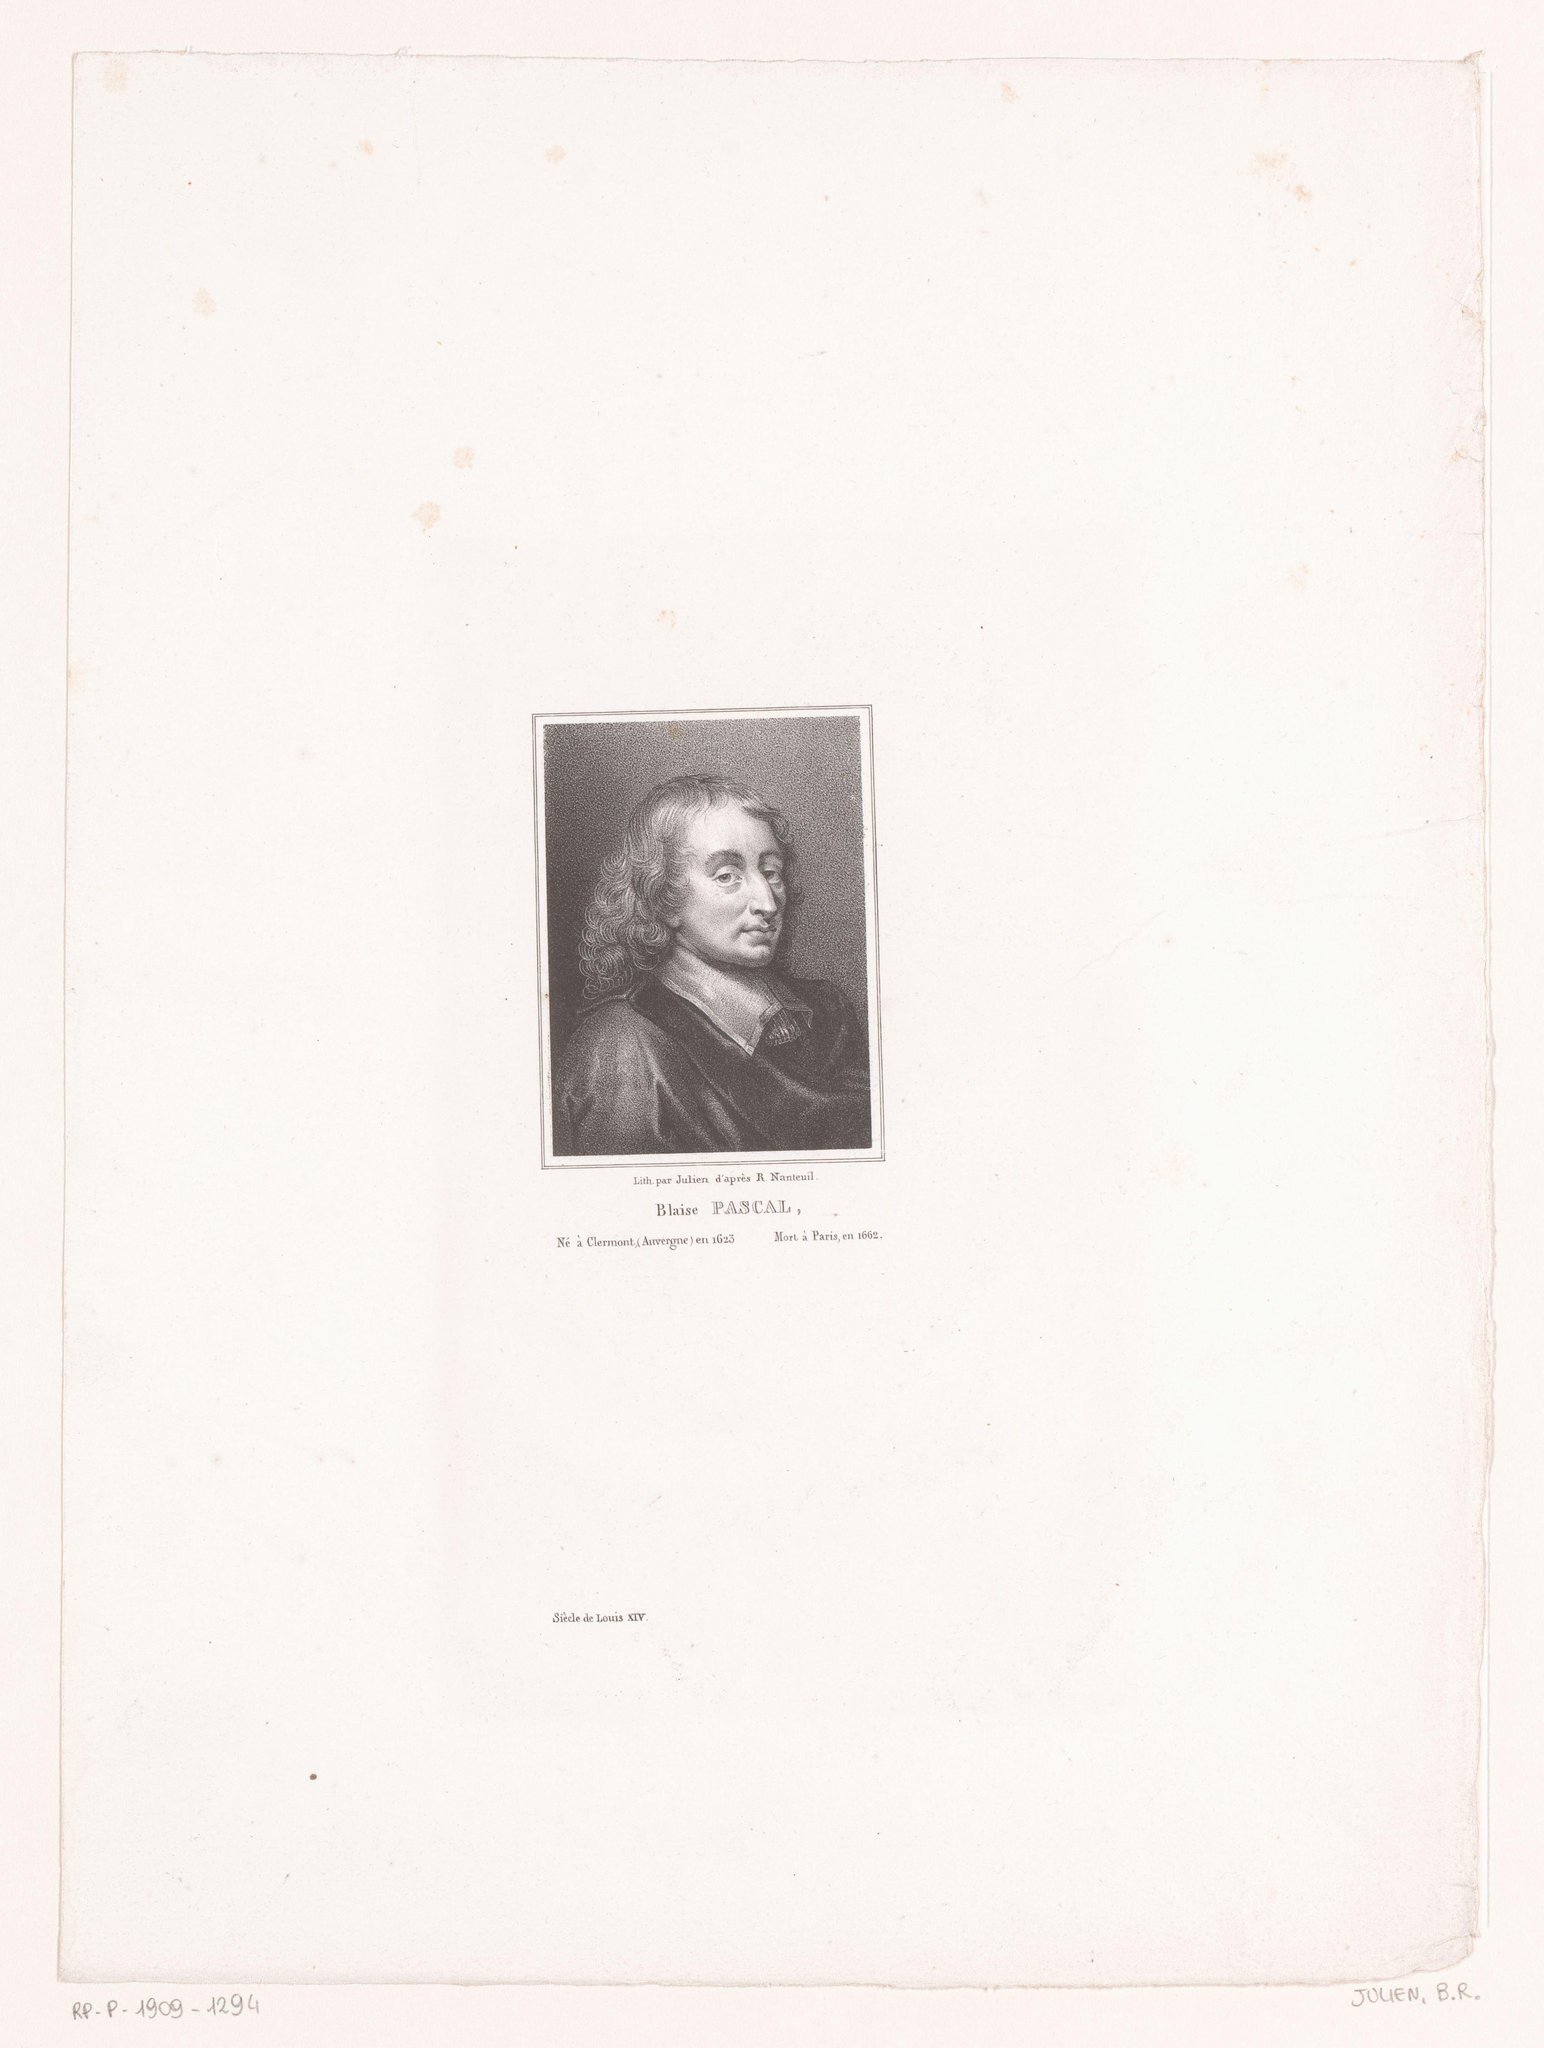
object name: print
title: Portret van Blaise Pascal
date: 1830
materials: paper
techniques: lithograph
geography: paris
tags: paris, historical persons, portrait of a writer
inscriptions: collector's mark: Lugt 2228a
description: Prent gebruikt voor: Illustrations du Cours de Littérature de la Harpe, ou collection de 400 portraits destinés à l'ornement de cet ouvrage. Parijs: Boblet, 1830.